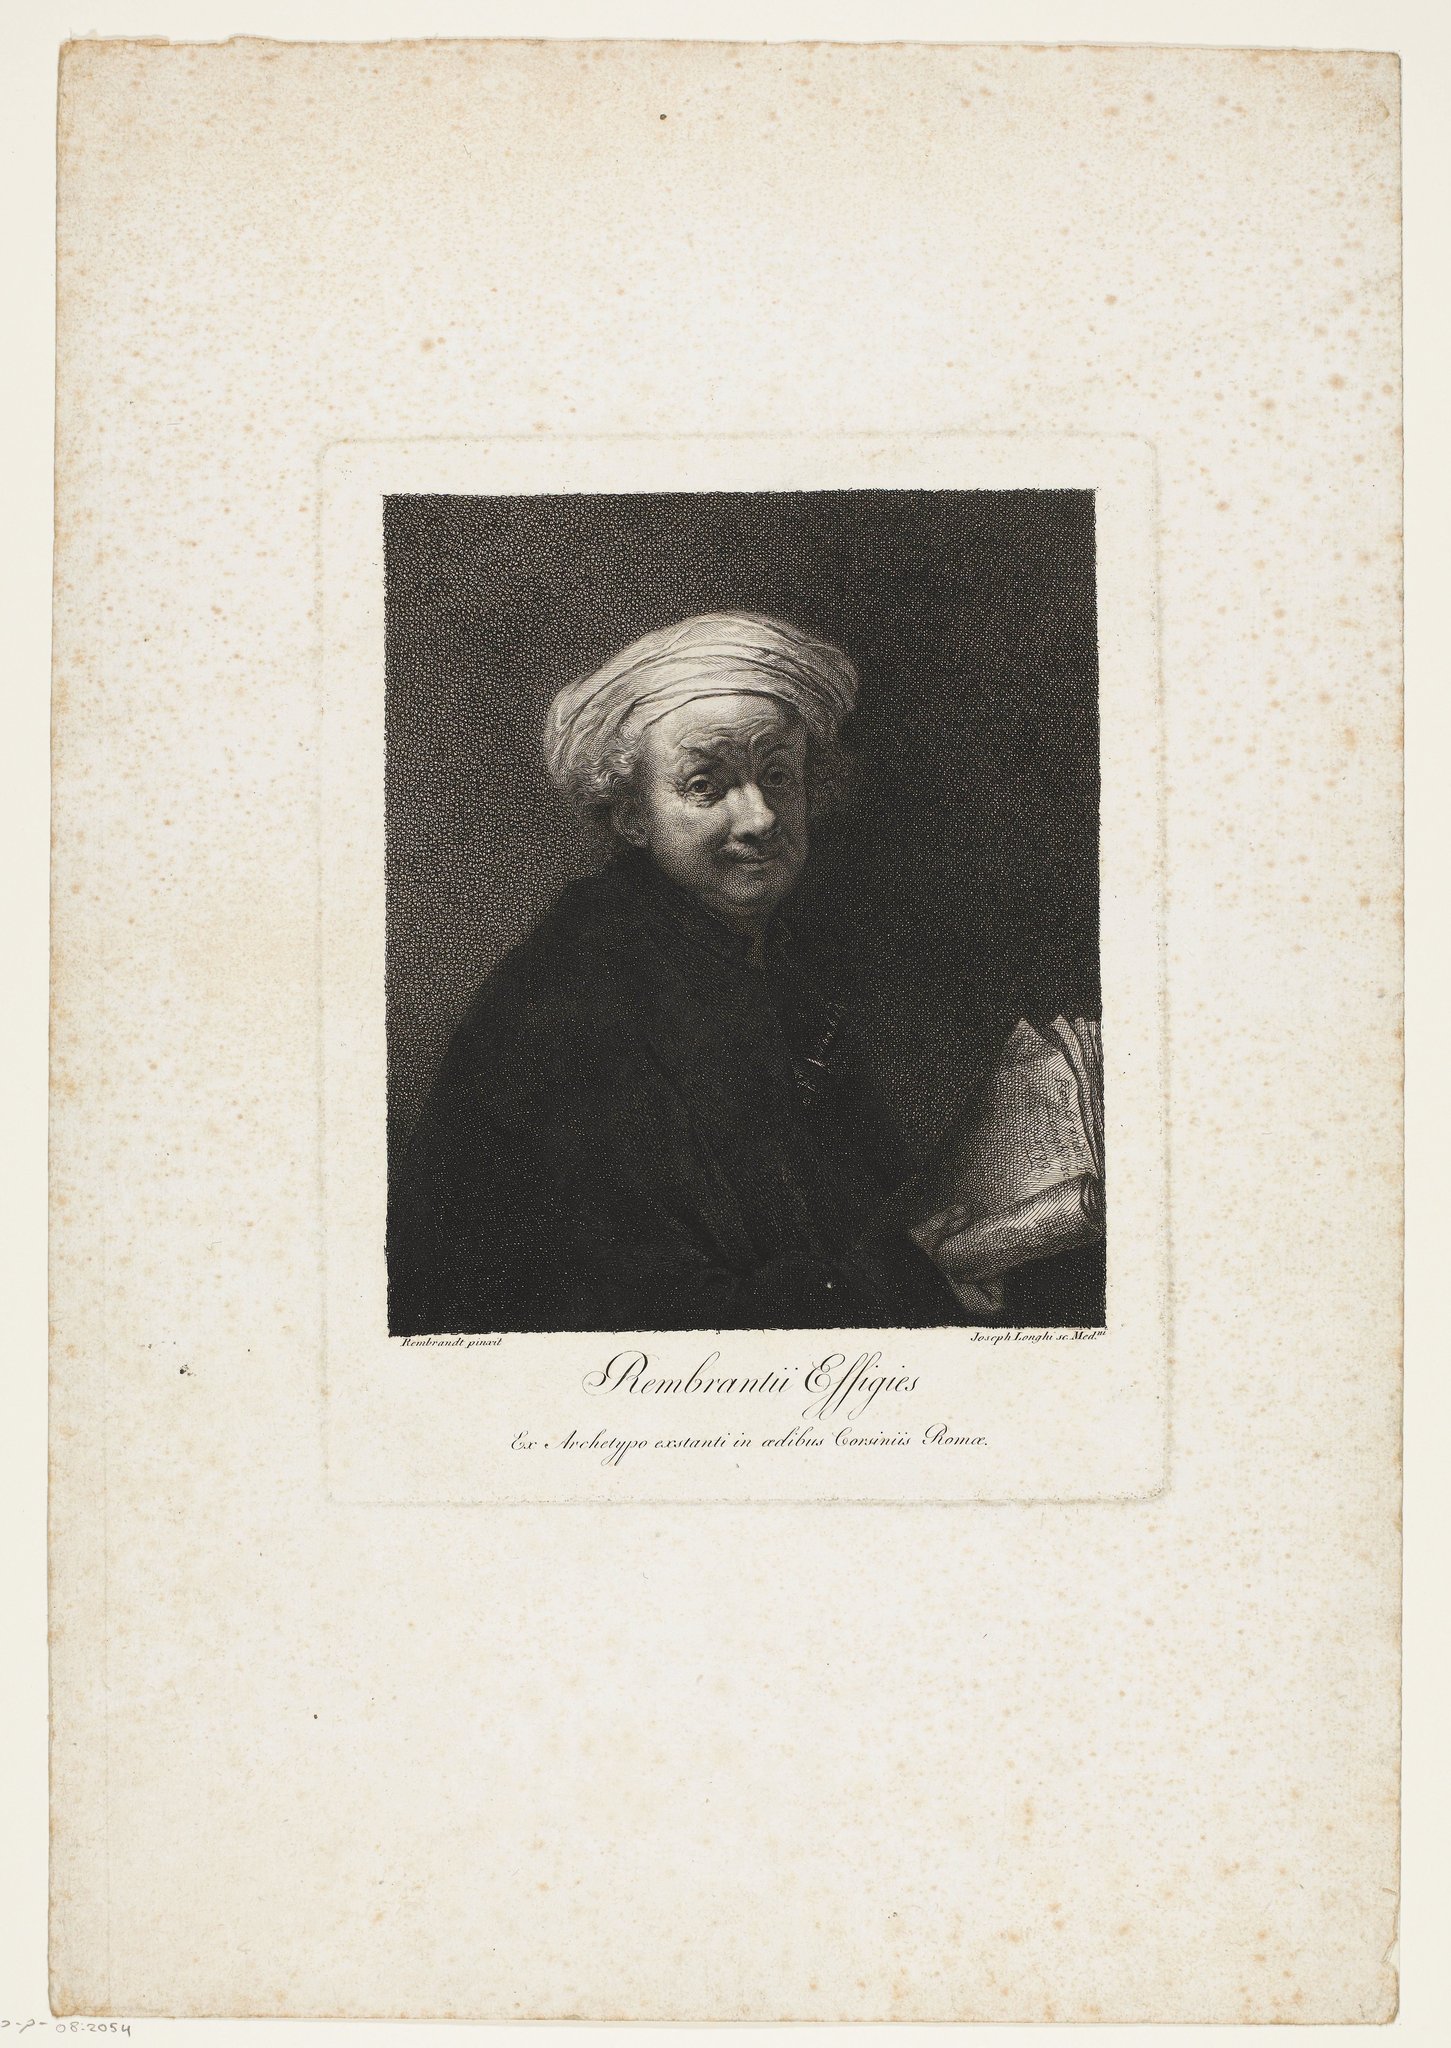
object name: print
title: Rembrantii Effigies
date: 1799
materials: paper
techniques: etching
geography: italy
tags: leiden, amsterdam, painter, print maker, draughtsman, rembrandt van rijn, historical persons, portrait, self-portrait of artist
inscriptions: collector's mark: Lugt 2228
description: Naar geschilderd zelfportret door Rembrandt in het Rijksmuseum Amsterdam (inv. nr. SK-A-4050).